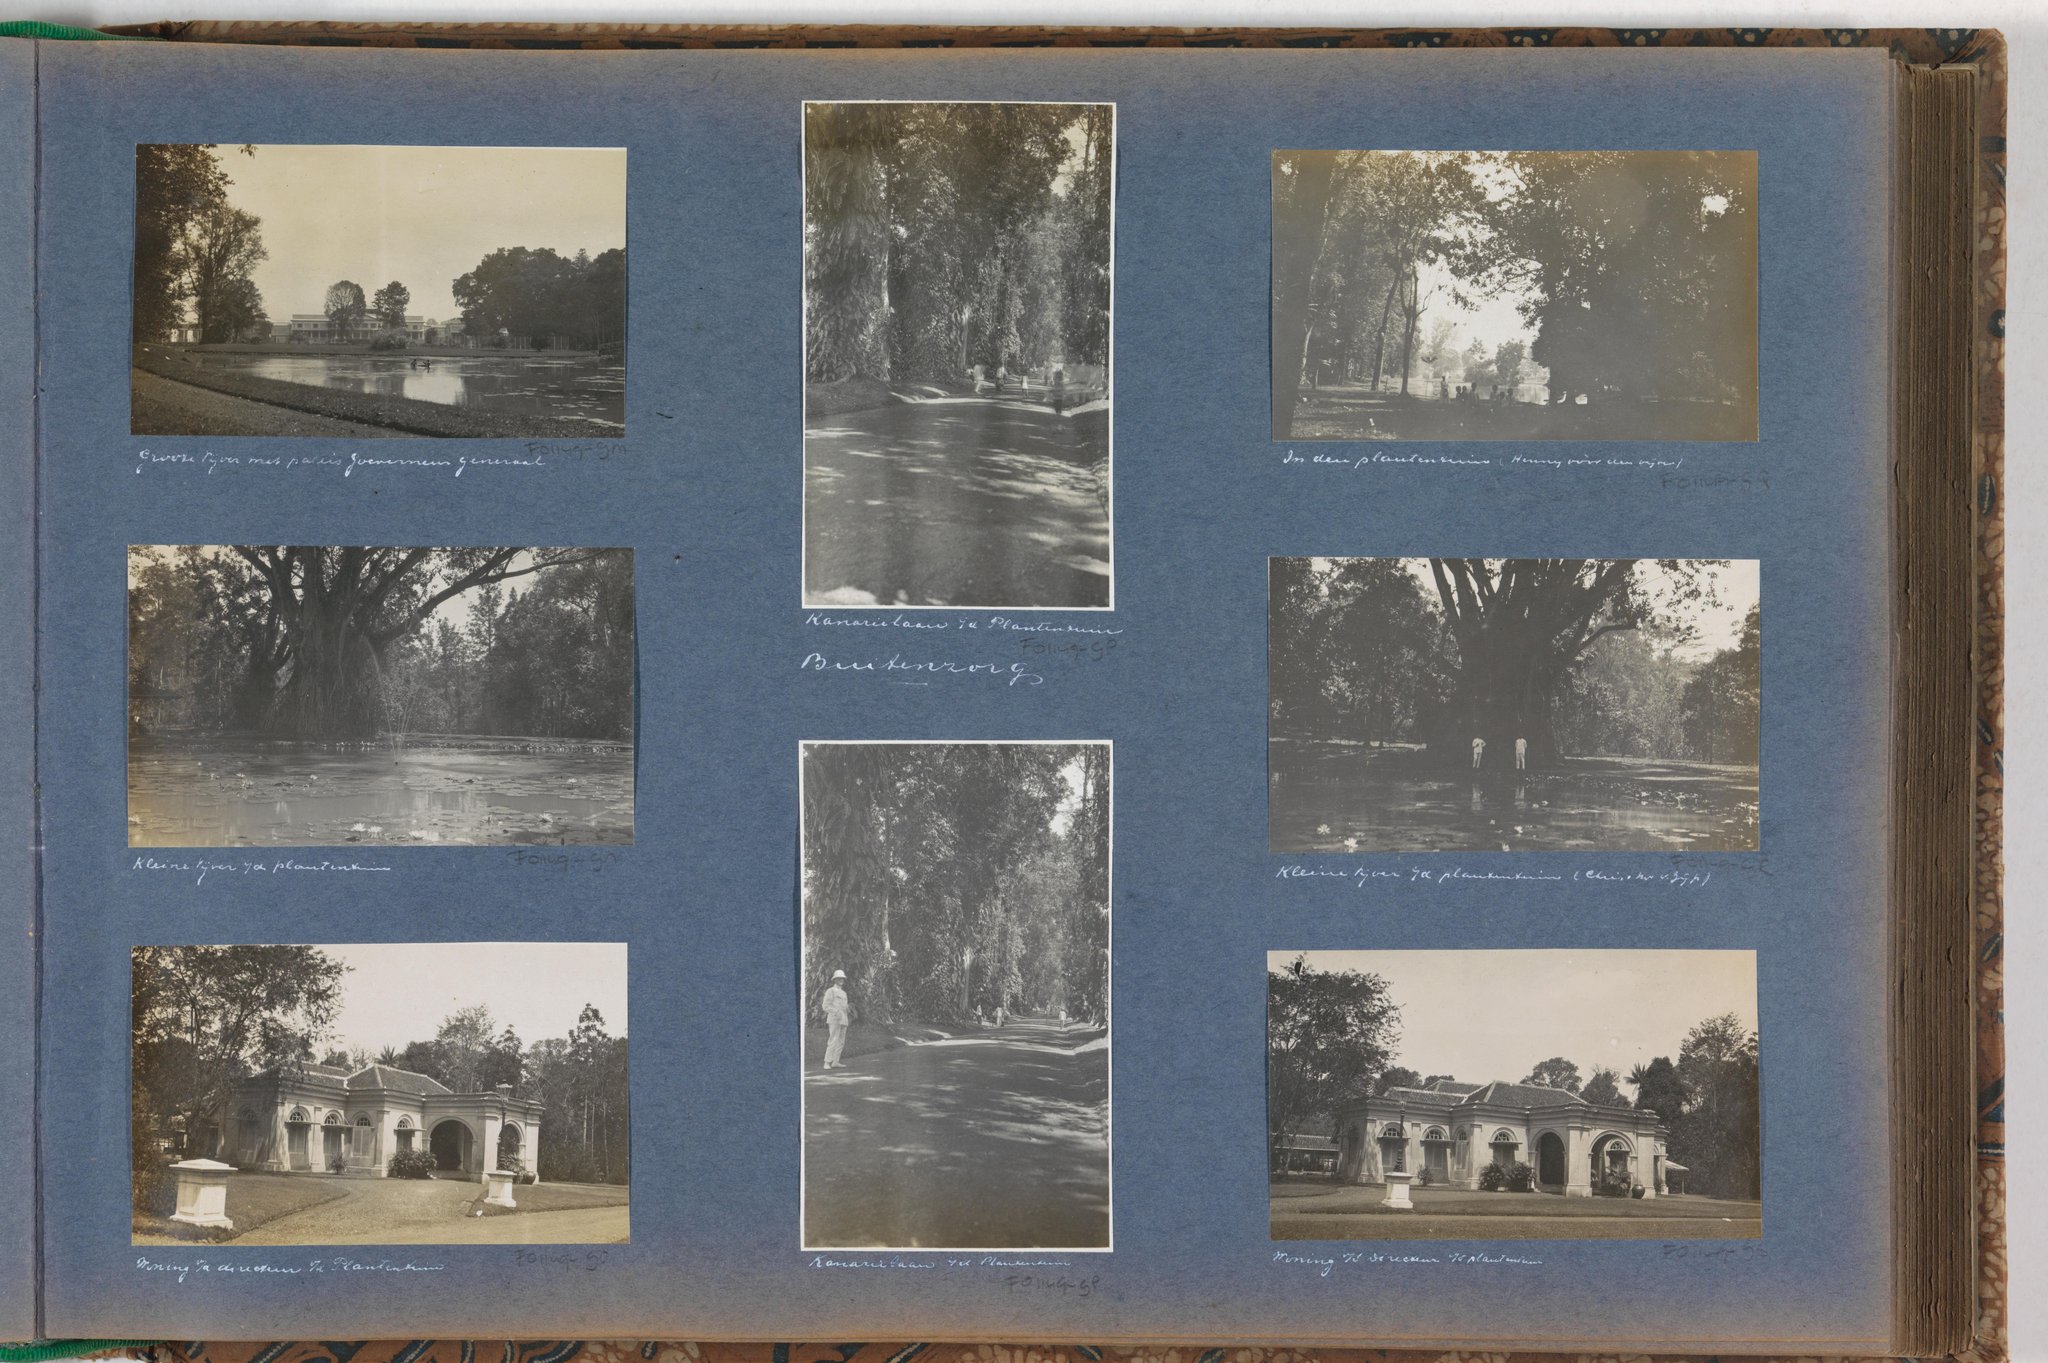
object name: photograph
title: Kanarielaan in 's Lands Plantentuin te Buitenzorg, op de voorgrond een Europeaan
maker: Anonymous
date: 1900-1920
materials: paper, photographic support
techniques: gelatin silver print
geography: s lands plantentuin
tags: botanic garden, 'hortus botanicus', lane, alley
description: Onderdeel van reisalbum met foto's van bedrijvigheid en bezienswaardigheden op Sumatra en Java en van de reis naar en van Nederlands-Indië.